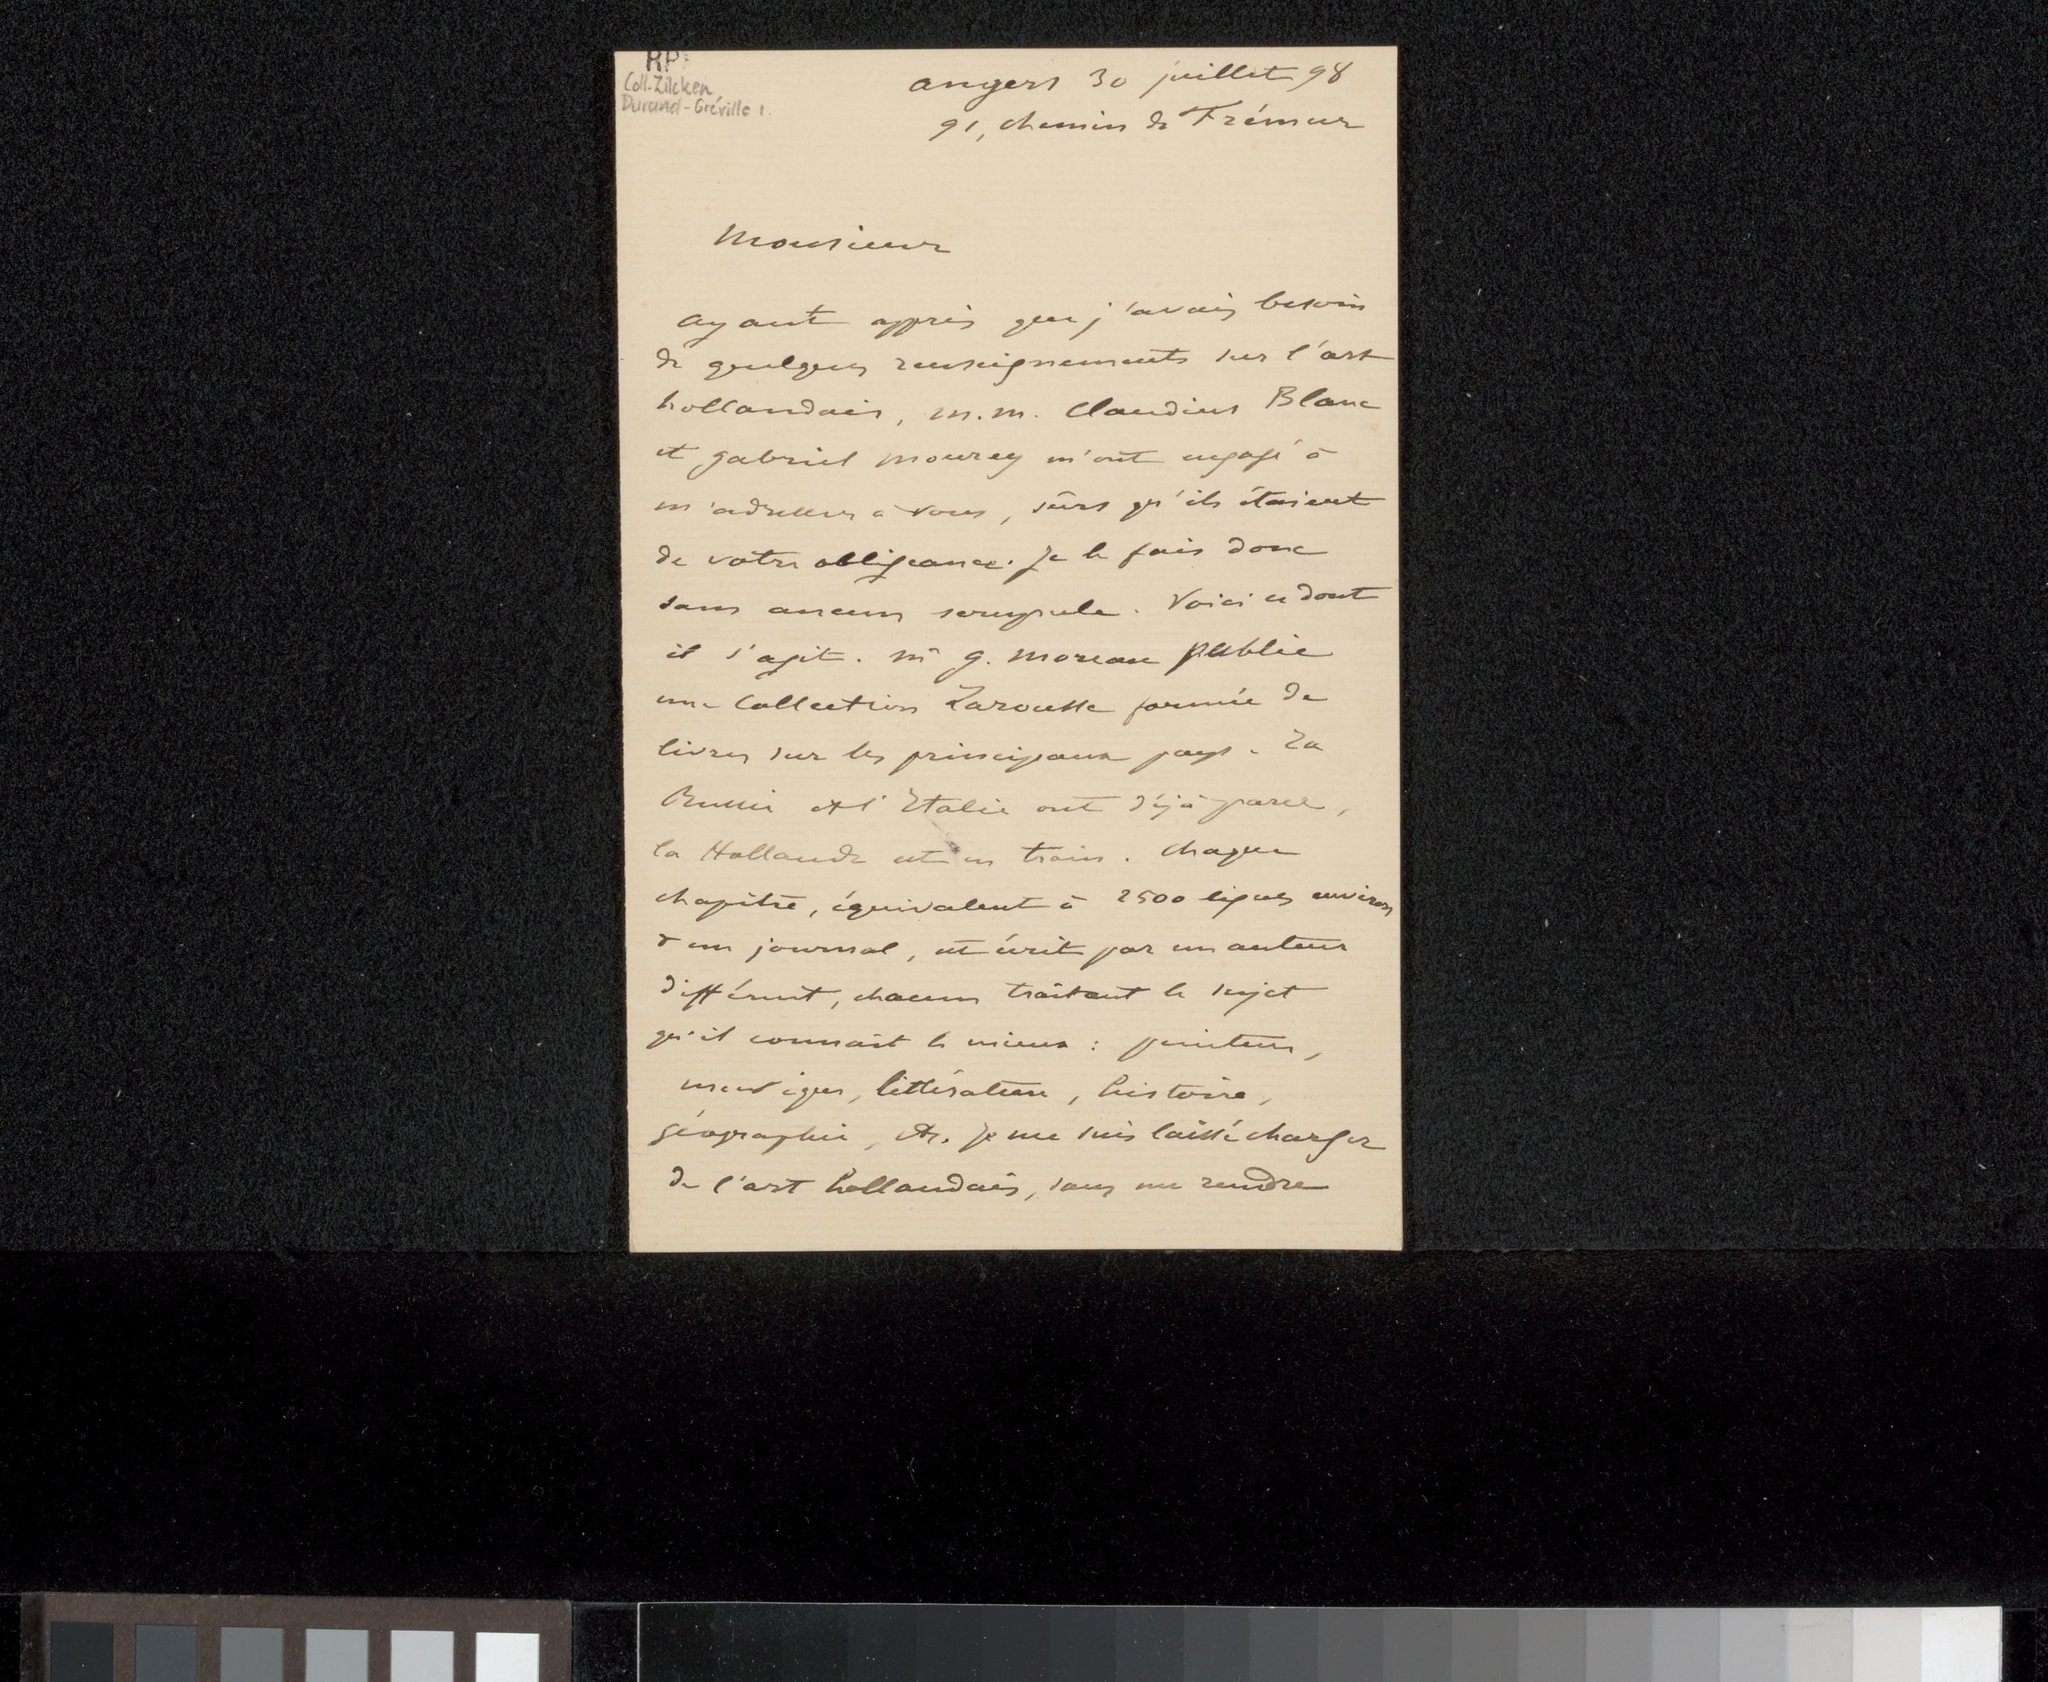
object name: letter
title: Brief aan Philip Zilcken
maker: émile durand-gréville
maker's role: schrijver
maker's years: 1838-1914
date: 1898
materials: ink, paper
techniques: pen, writing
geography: angers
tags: willem roelofs (i), hendrik jacobus scholten, jozef israëls, hendrik willem mesdag, the hague, painter, print maker, draughtsman, philip sadée, albert neuhuys (1844-1914), wouter verschuur (1812-1874), david adolph constant artz, amsterdam, johannes hermanus barend koekkoek, louis apol, willem carel nakken, leiden, rembrandt van rijn, claudius blanc, marseille, gabriel mourey, philip zilcken, sculpture, painting (including book-illumination, miniature-painting)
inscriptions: collector's mark: ‘RPK’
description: Brief bevat een lijst met namen van kunstenaars.